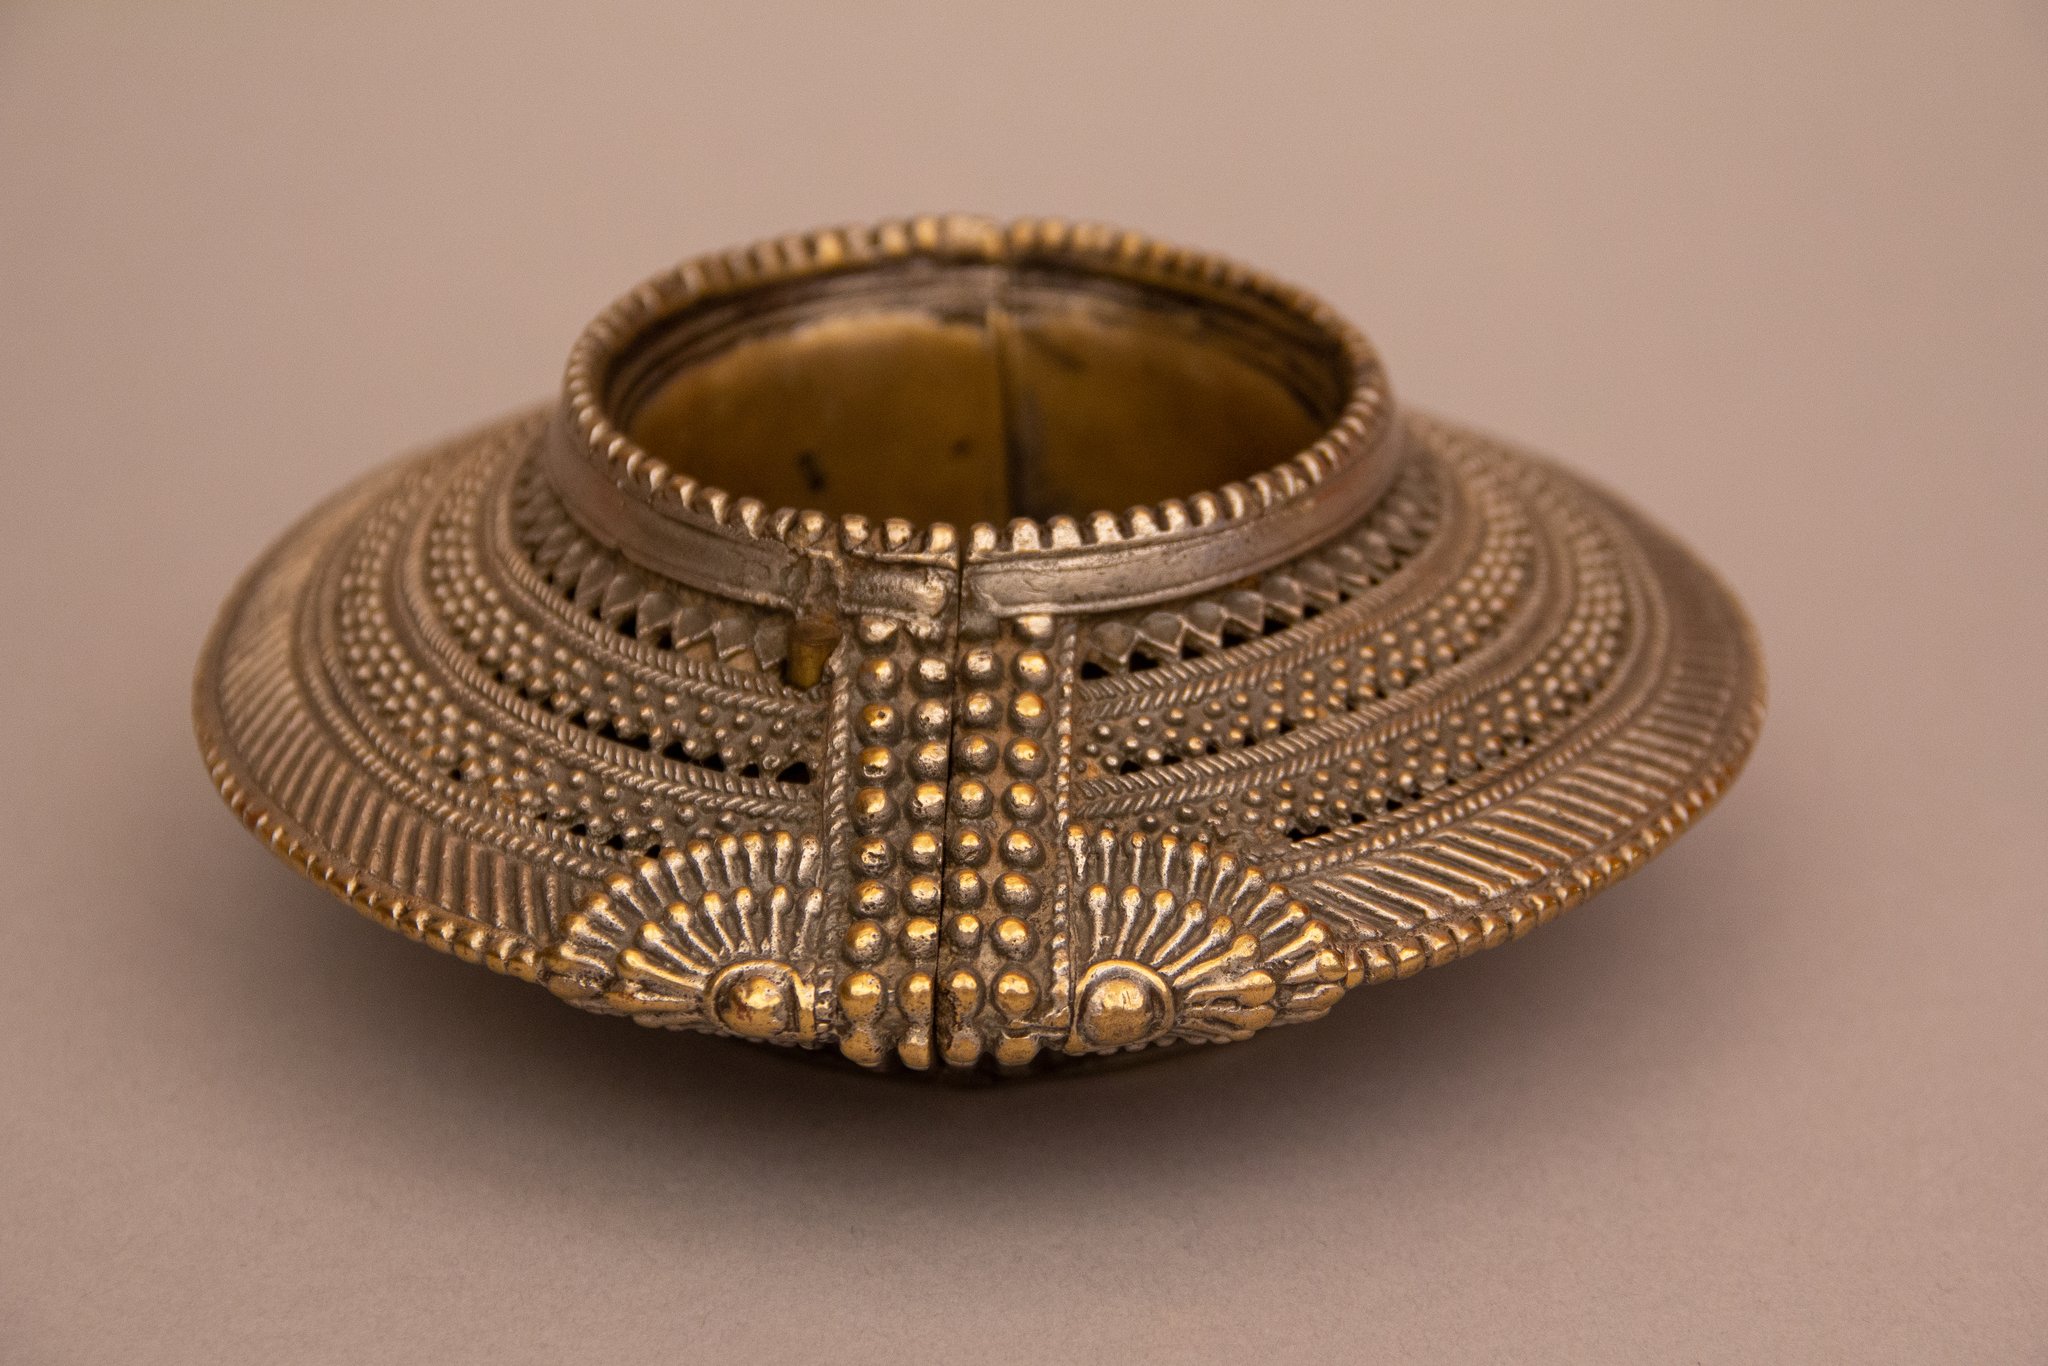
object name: anklet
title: Anklet, One of a Pair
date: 1801-1900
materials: silver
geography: india